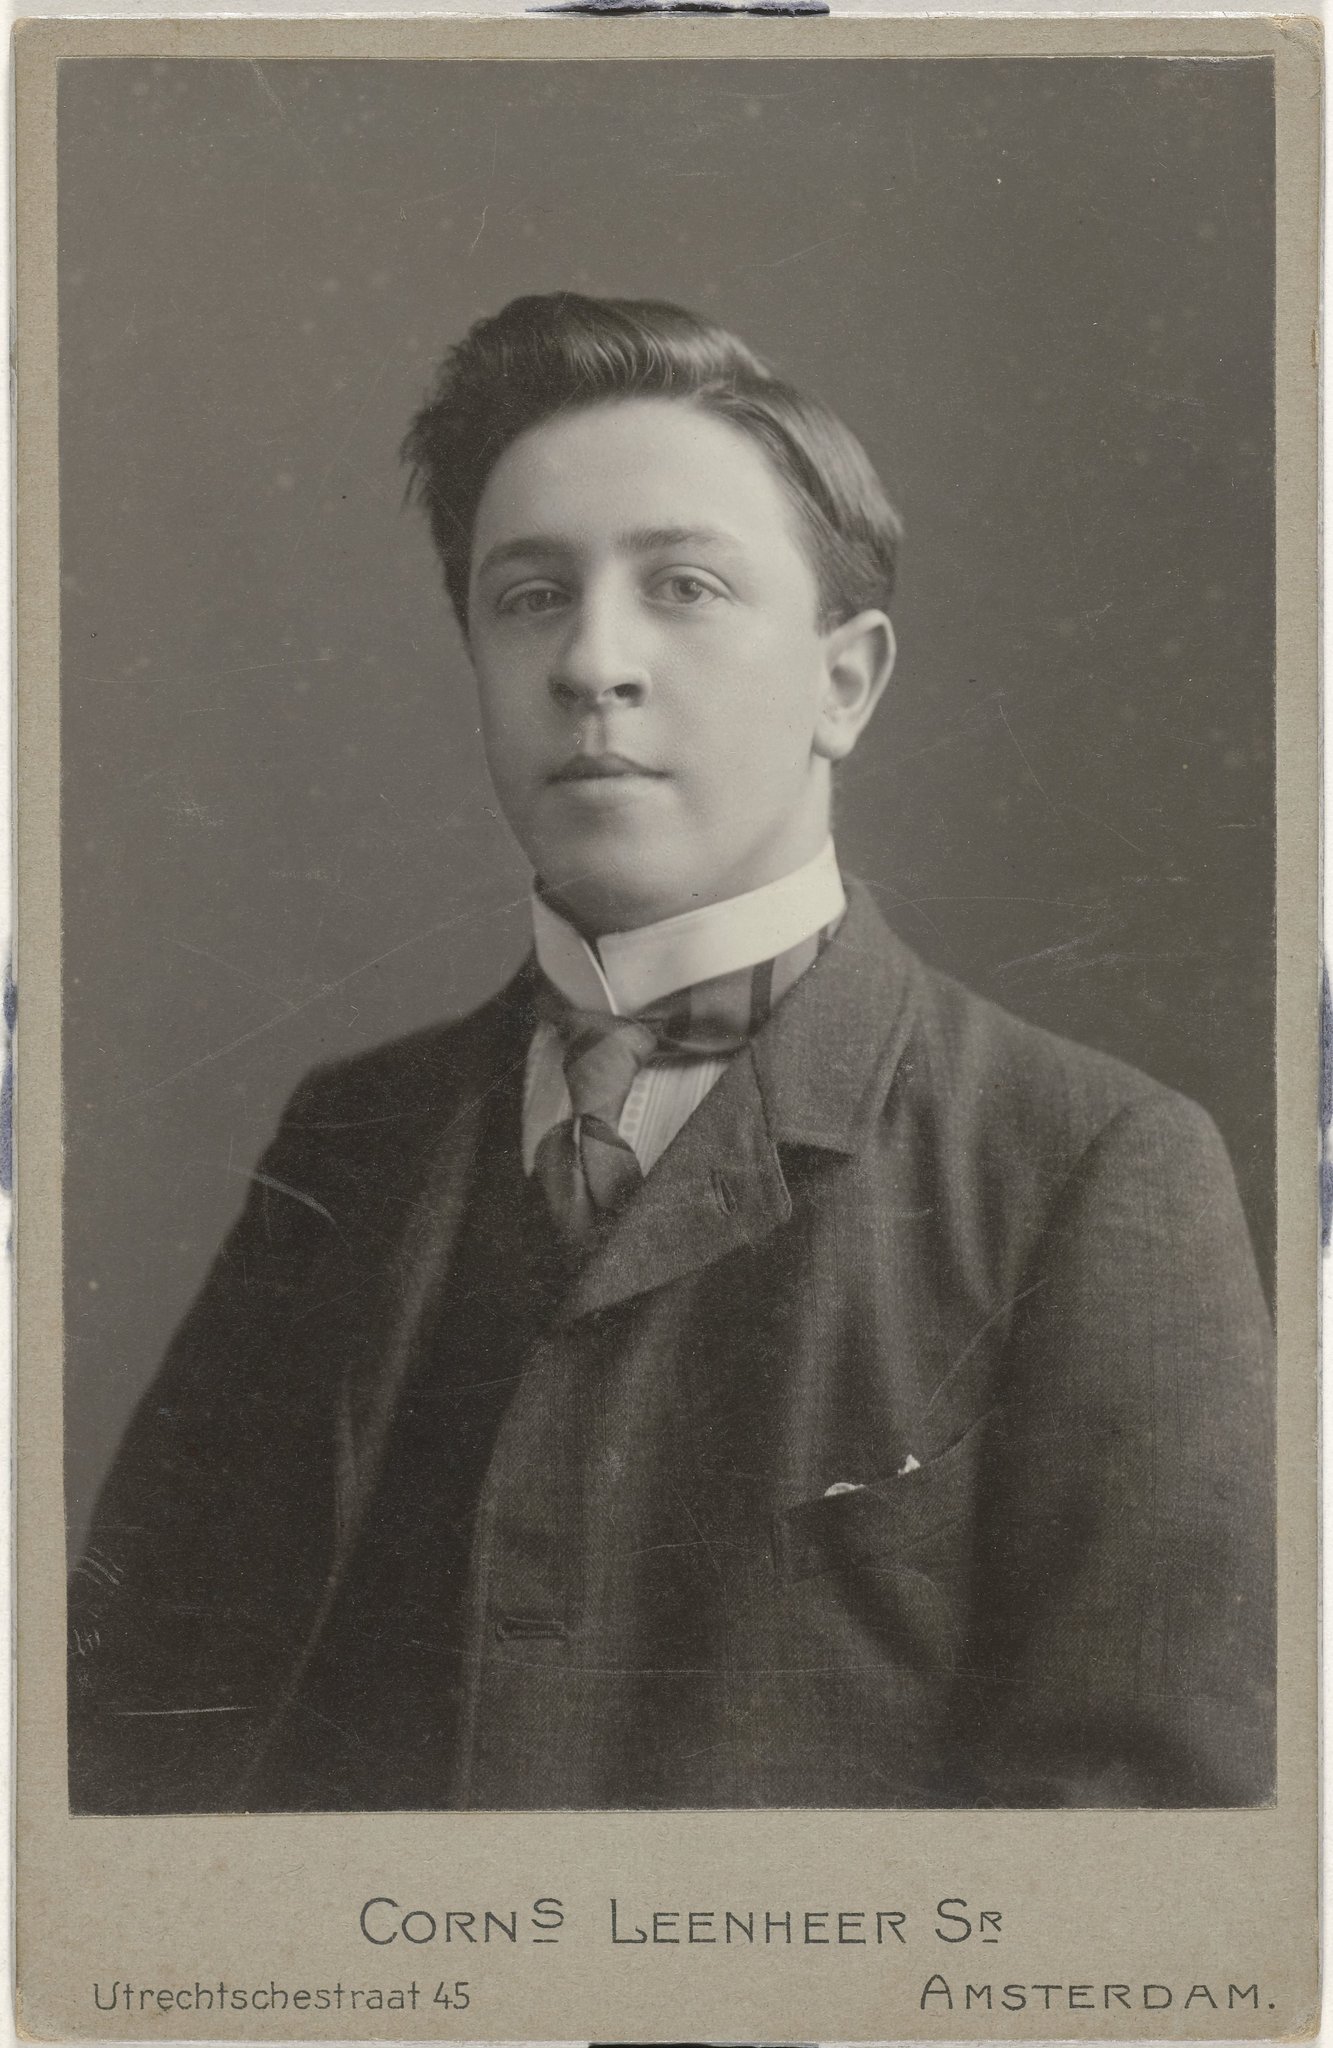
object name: photograph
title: Studioportret van een man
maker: cornelis leenheer sr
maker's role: fotograaf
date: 1890-1920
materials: cardboard, photographic support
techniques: gelatin silver print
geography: amsterdam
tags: amsterdam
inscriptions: name: ‘Corn-s Leenheer Sr Utrechtsestraat 45 Amsterdam’